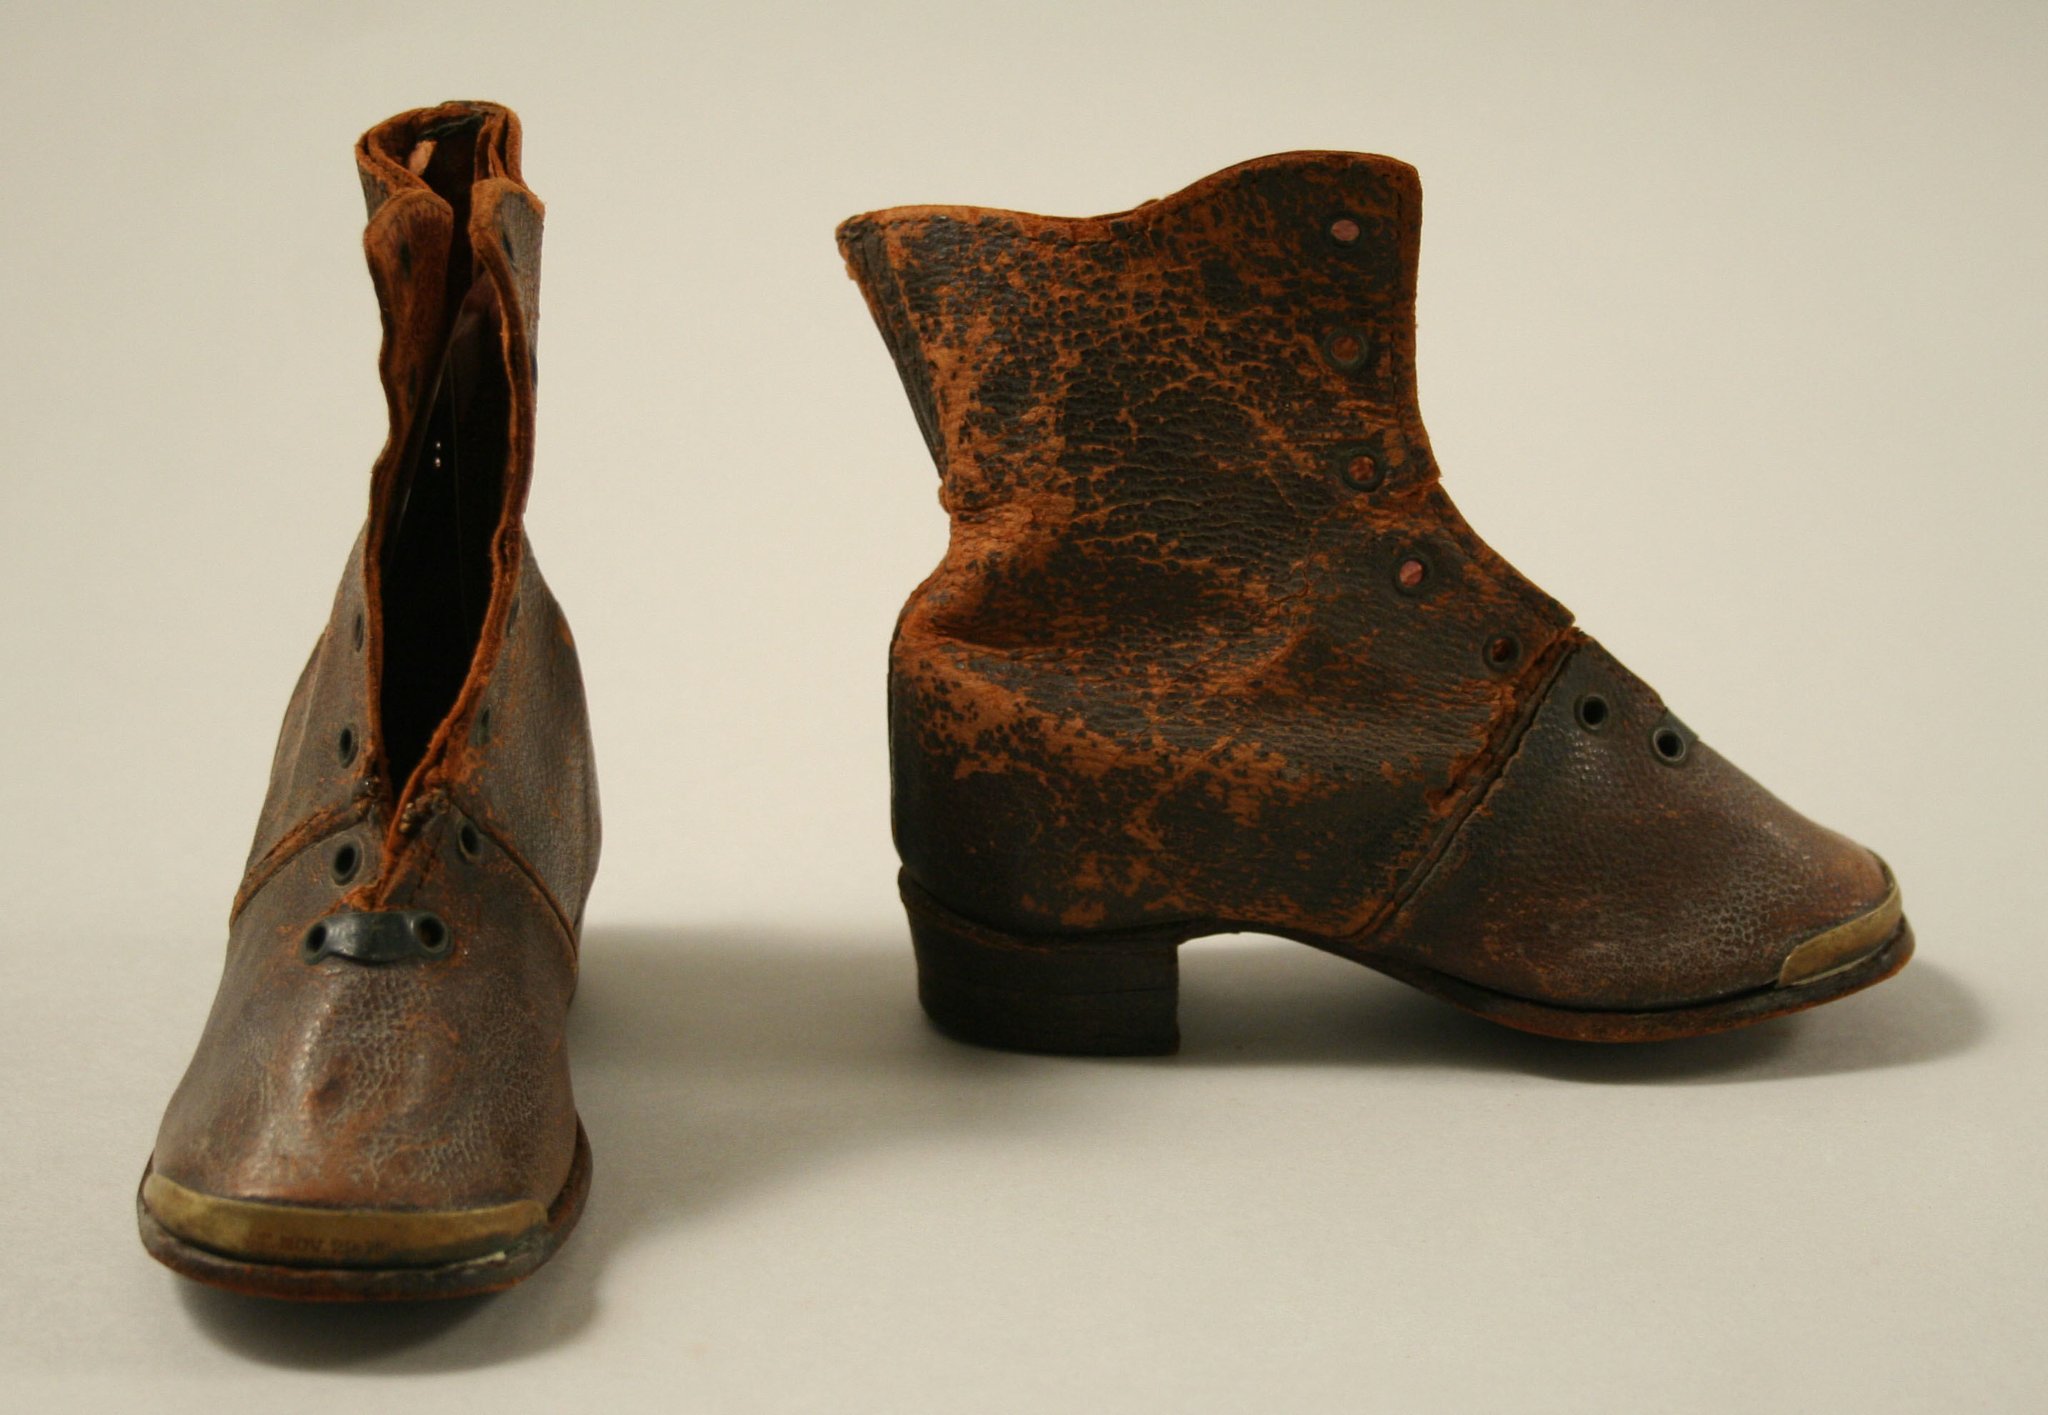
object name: shoe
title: Shoes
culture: american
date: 1859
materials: leather, metal, wood